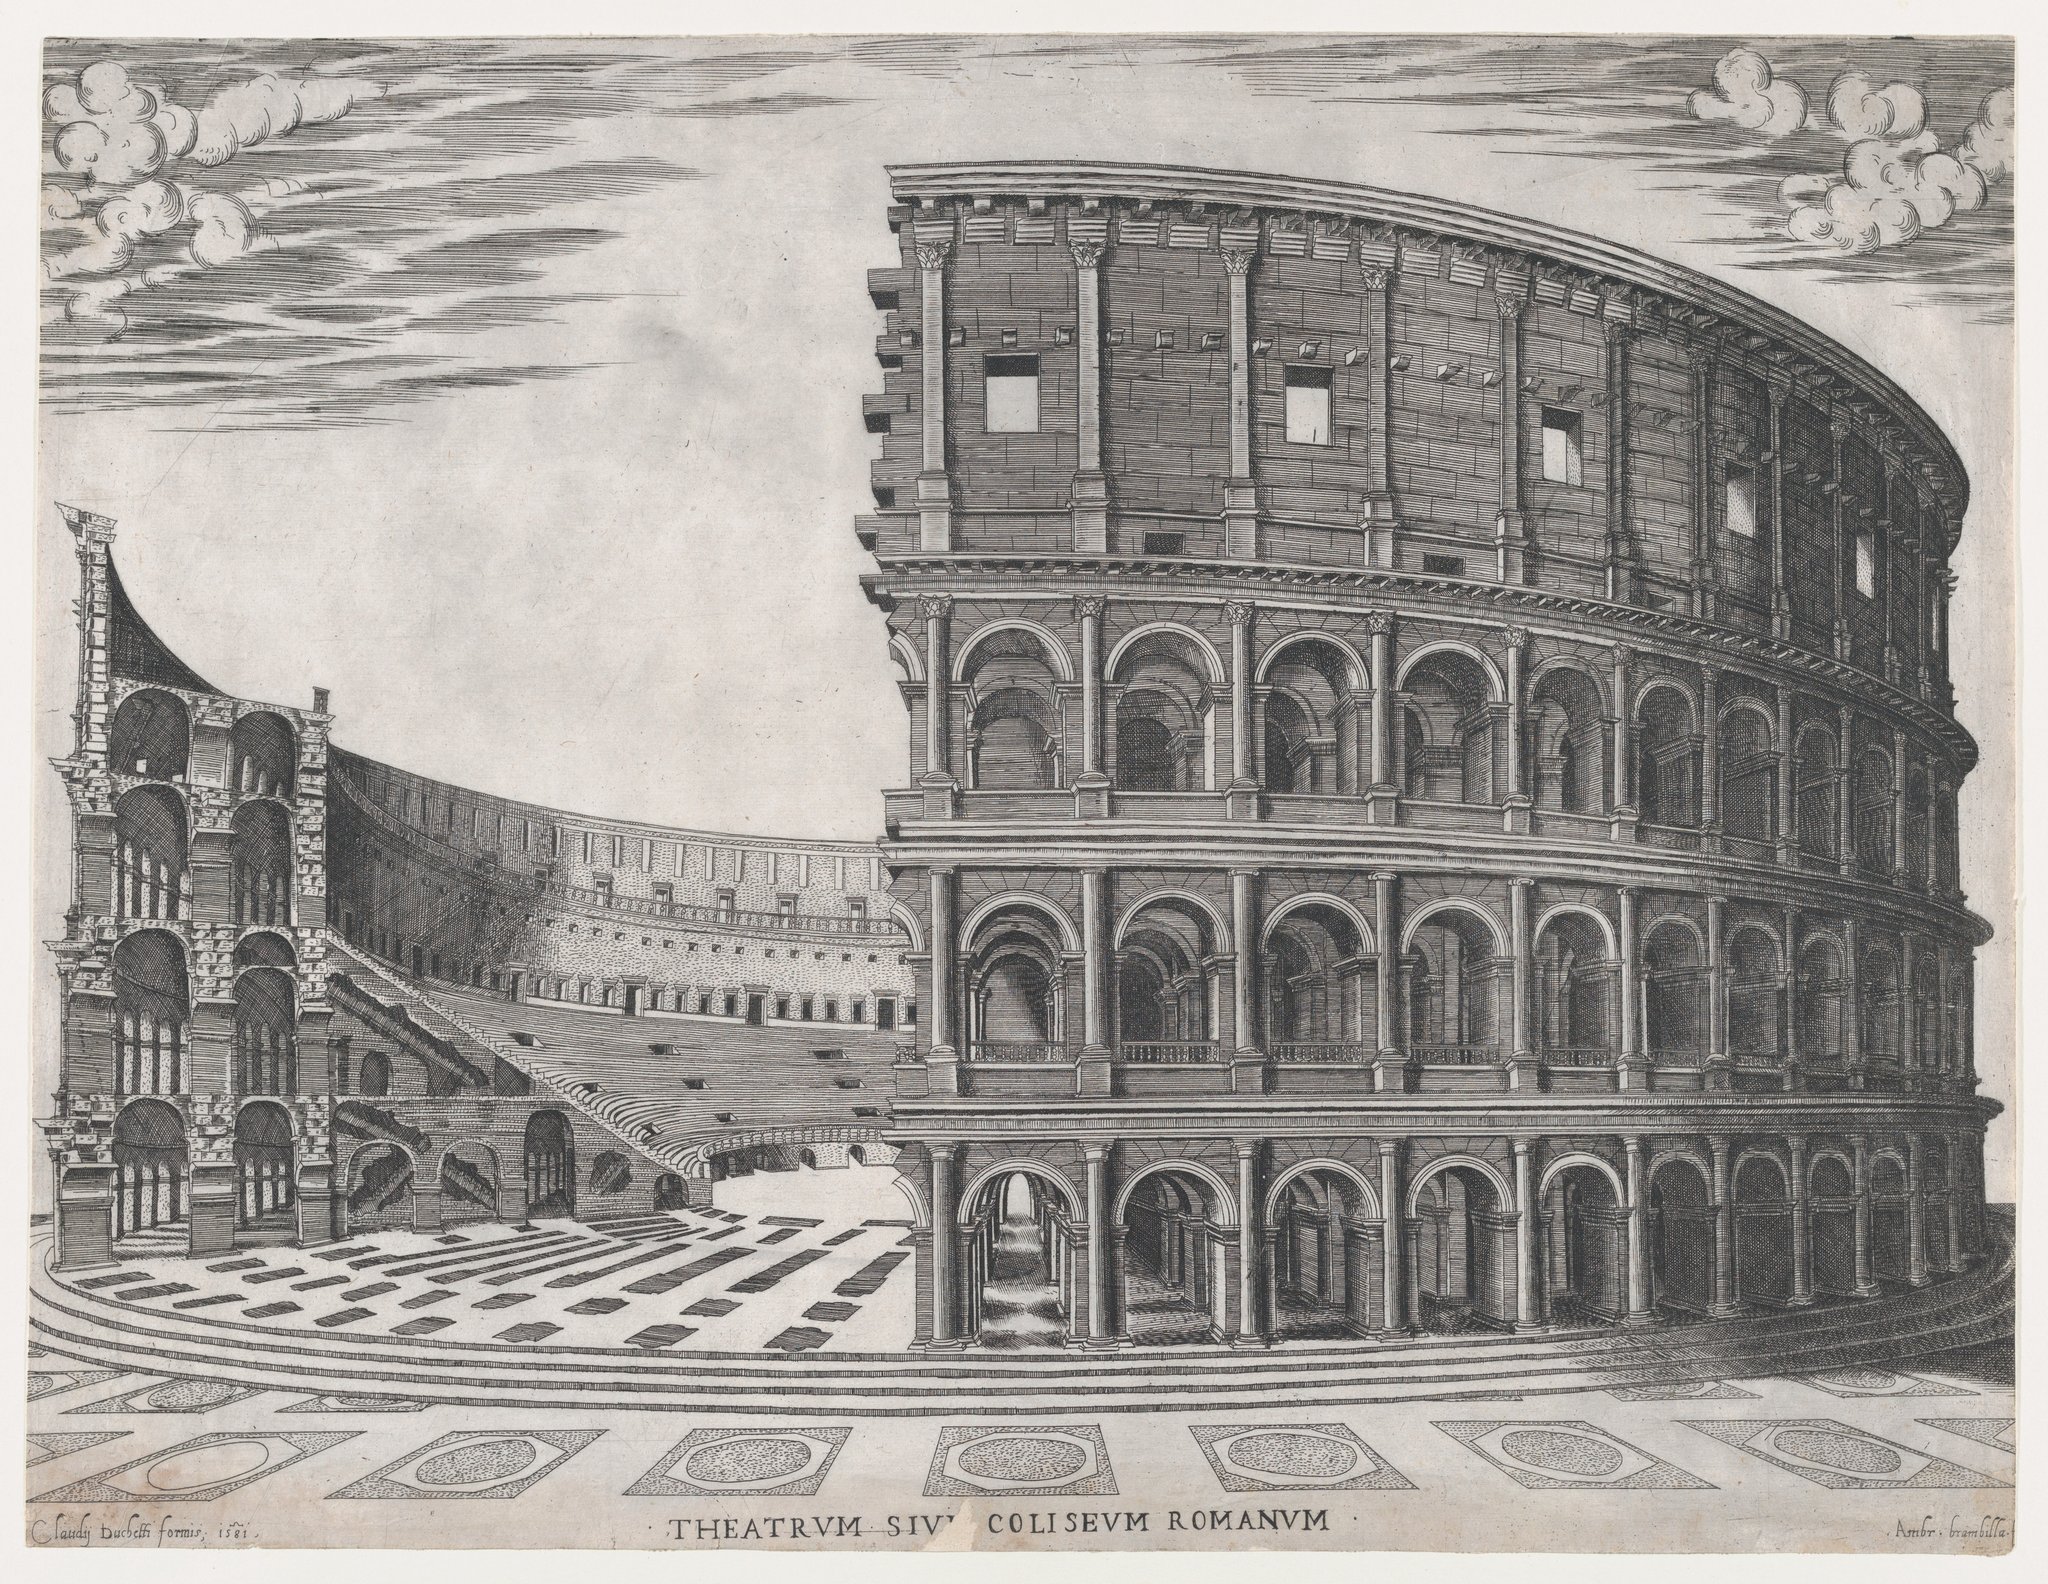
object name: print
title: The Colosseum, from "Speculum Romanae Magnificentiae"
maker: giovanni ambrogio brambilla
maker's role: artist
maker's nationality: italian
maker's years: 1575-1599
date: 1581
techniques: engraving, etching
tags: architecture,rome